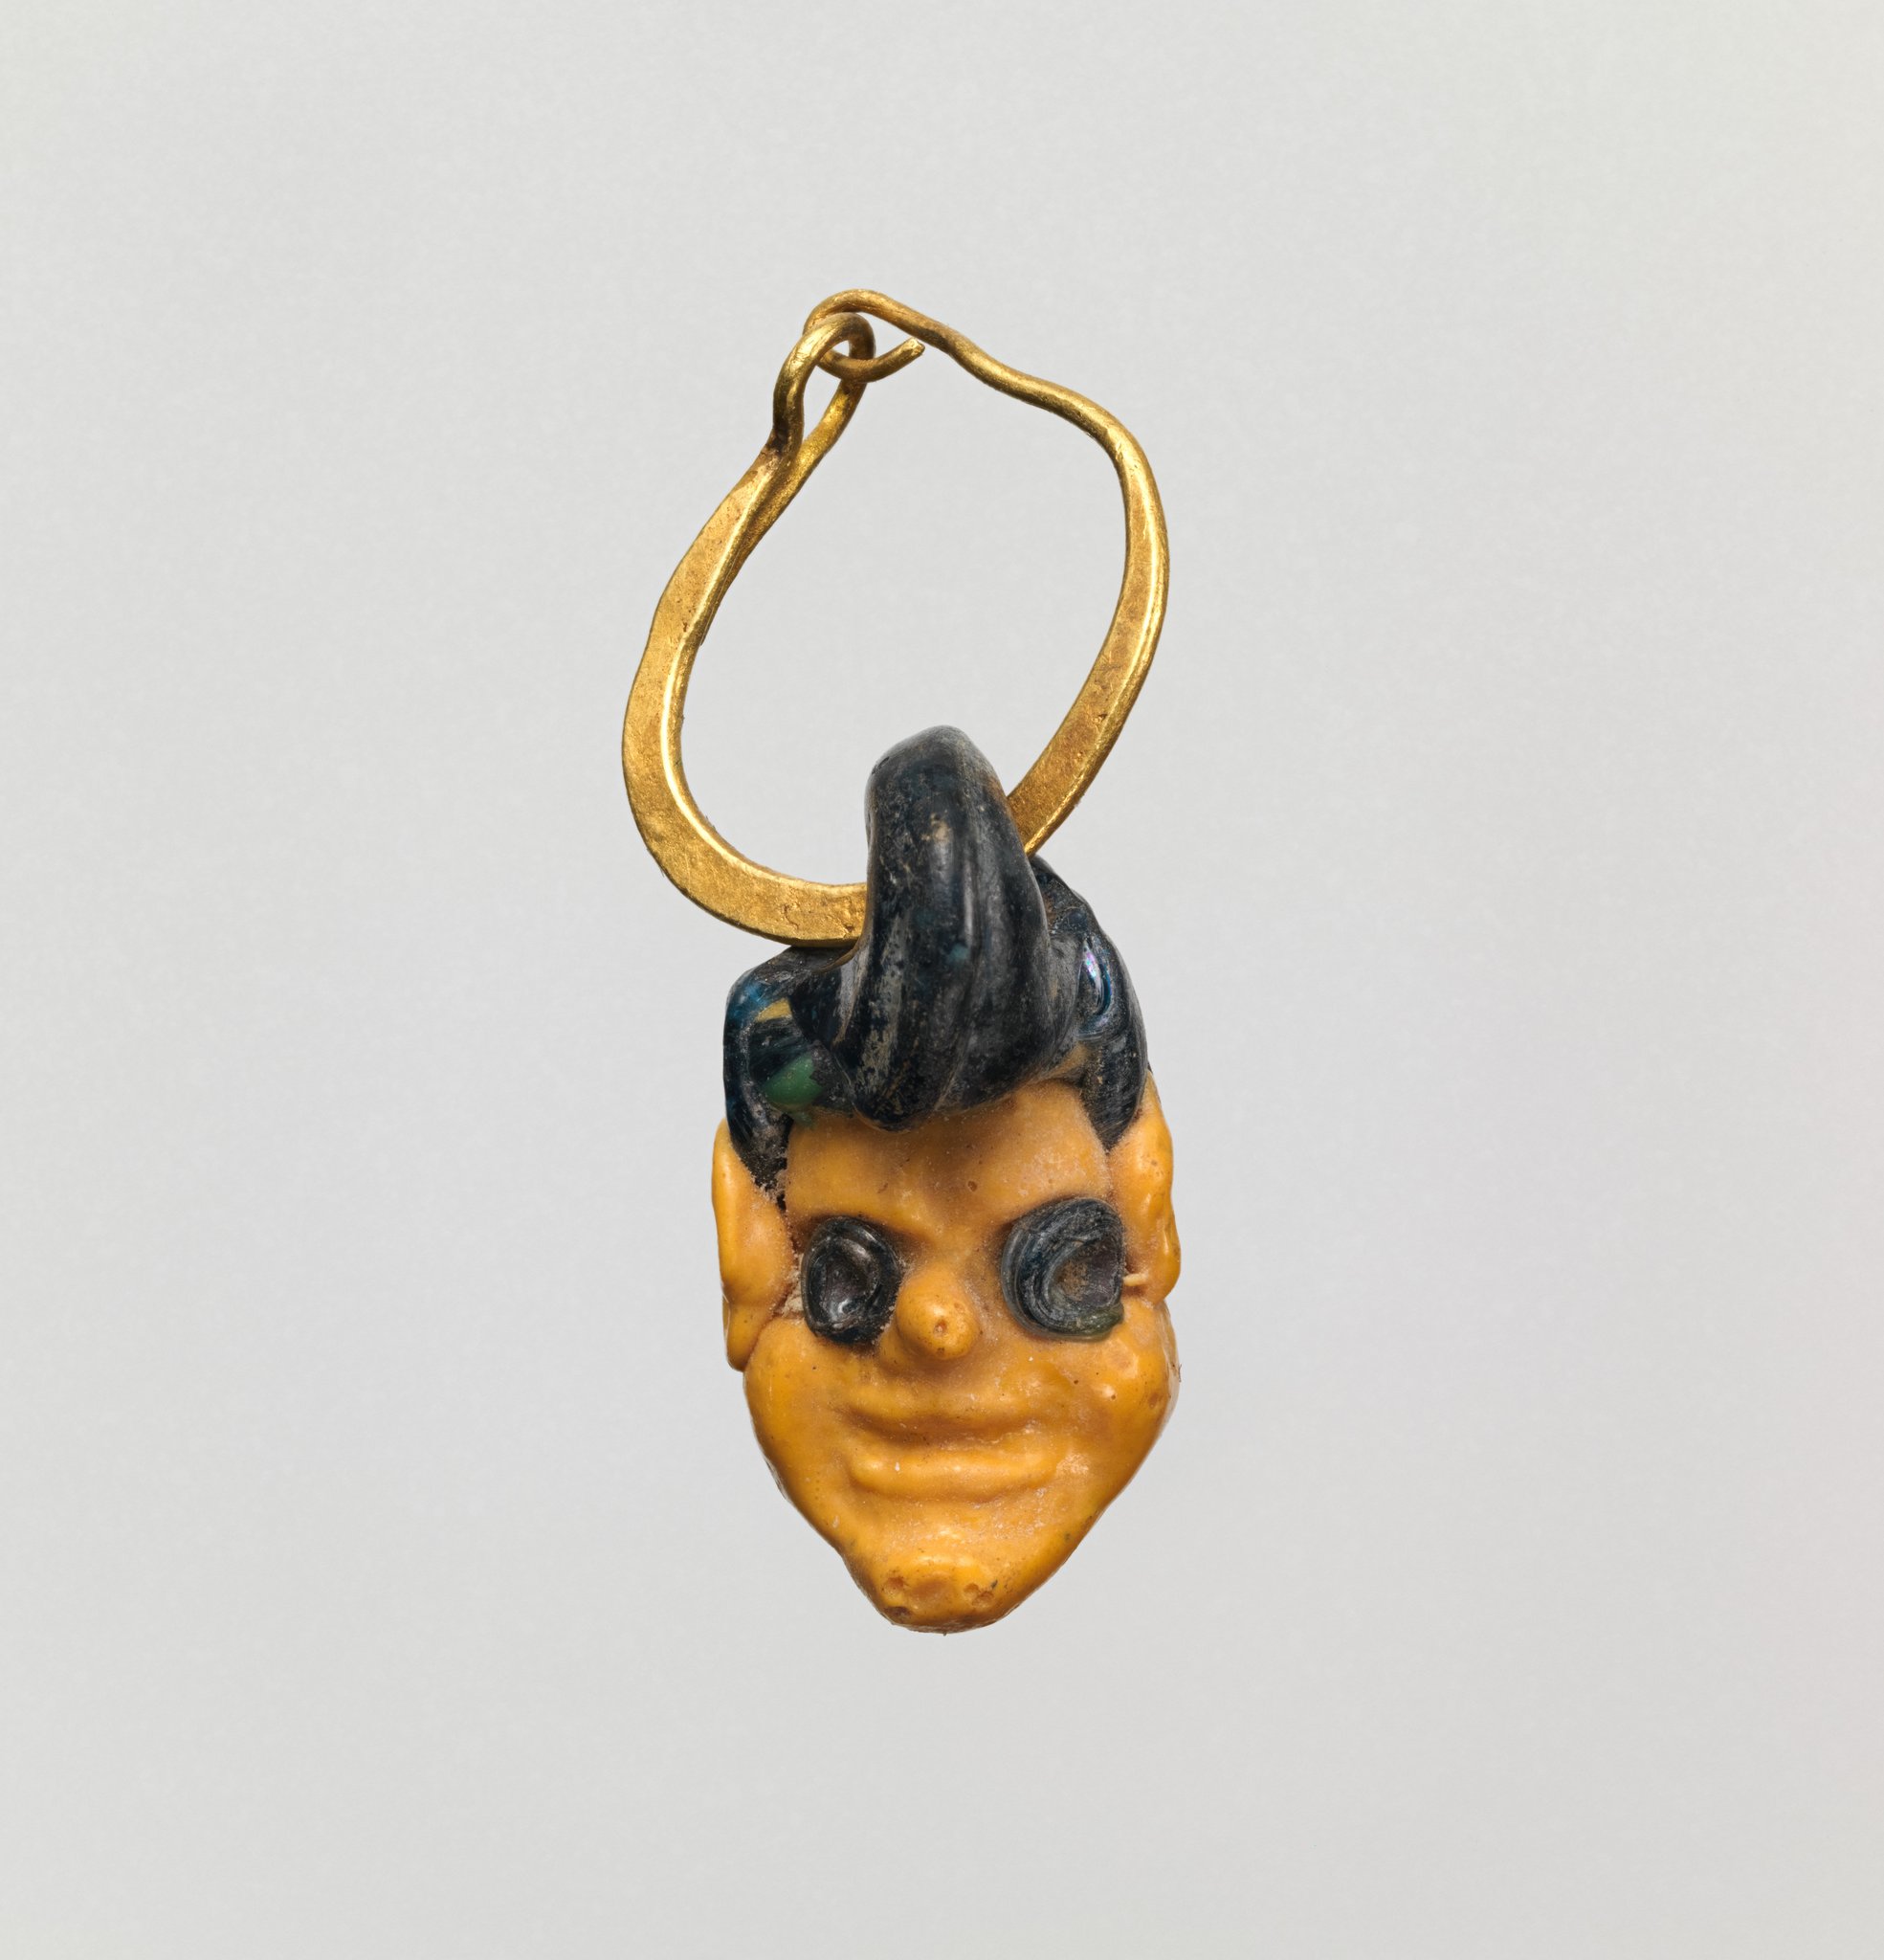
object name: earring with anthropomorphic pendant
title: Gold earring with glass head pendant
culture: carthaginian or phoenician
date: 300-1 BCE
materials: glass, gold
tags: heads